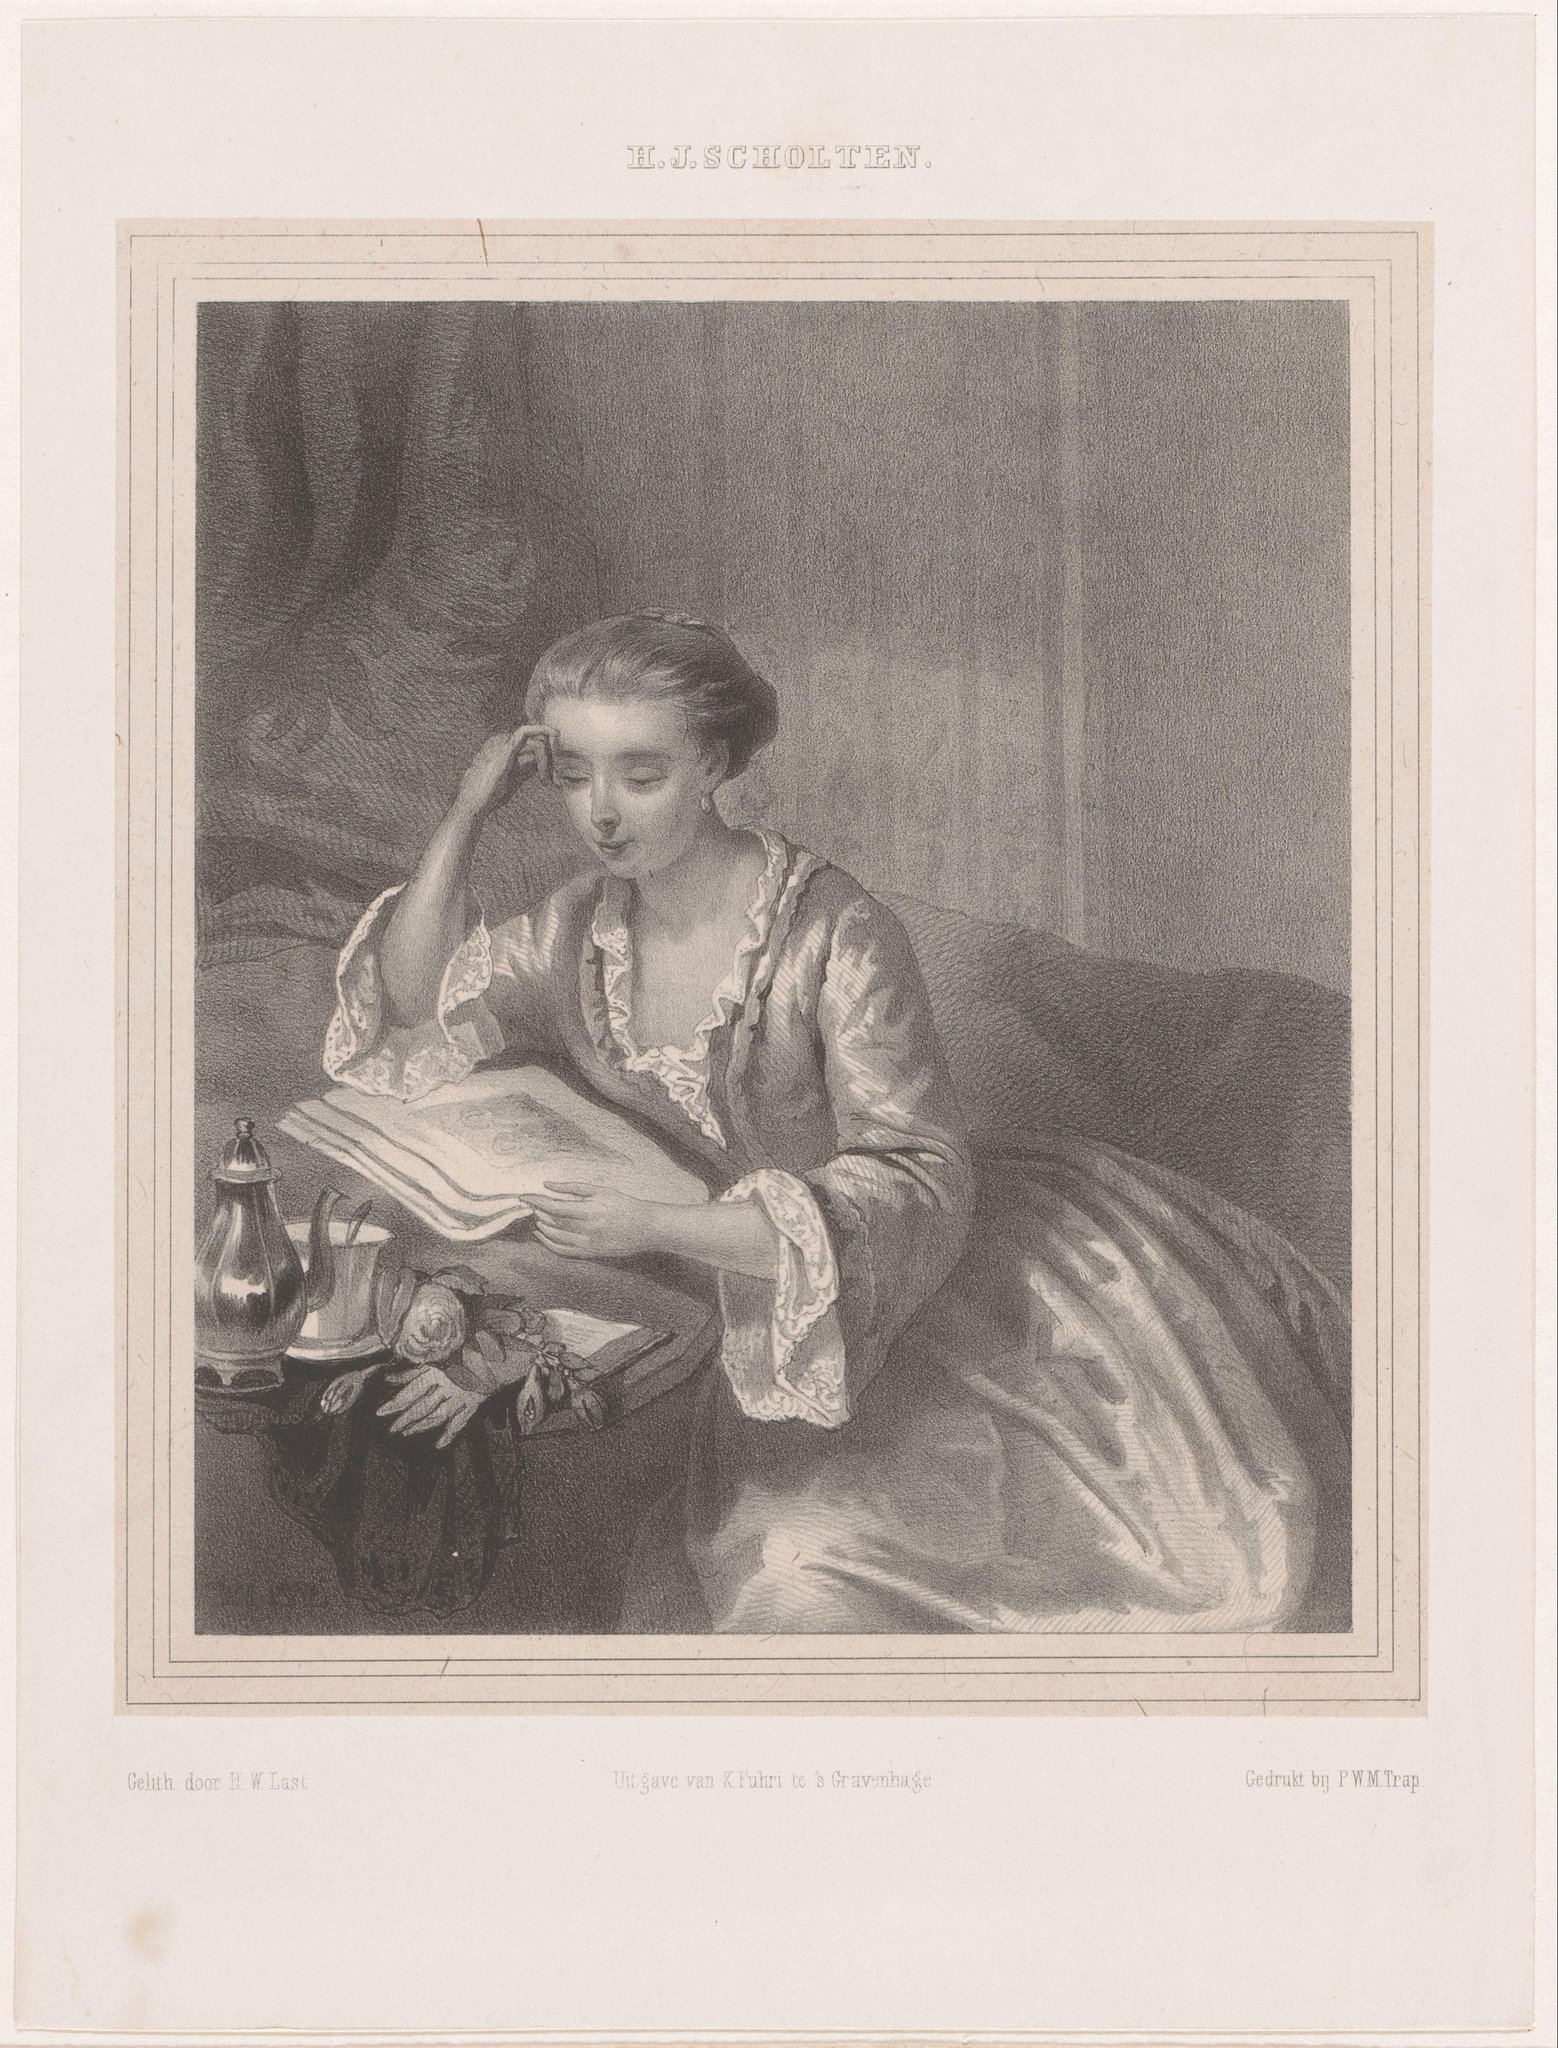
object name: print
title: Vrouw bekijkt prenten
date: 1837-1855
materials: paper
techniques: lithograph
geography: leiden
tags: coffee-pot, adolescent, young woman, maiden, print, e.g.: engraving, etching, lithograph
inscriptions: collector's mark: Lugt 2228, collector's mark: Lugt 2760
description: De vrouw leunt op haar rechterarm. Voor haar op tafel een koffiepot, handschoenen en bloemen.